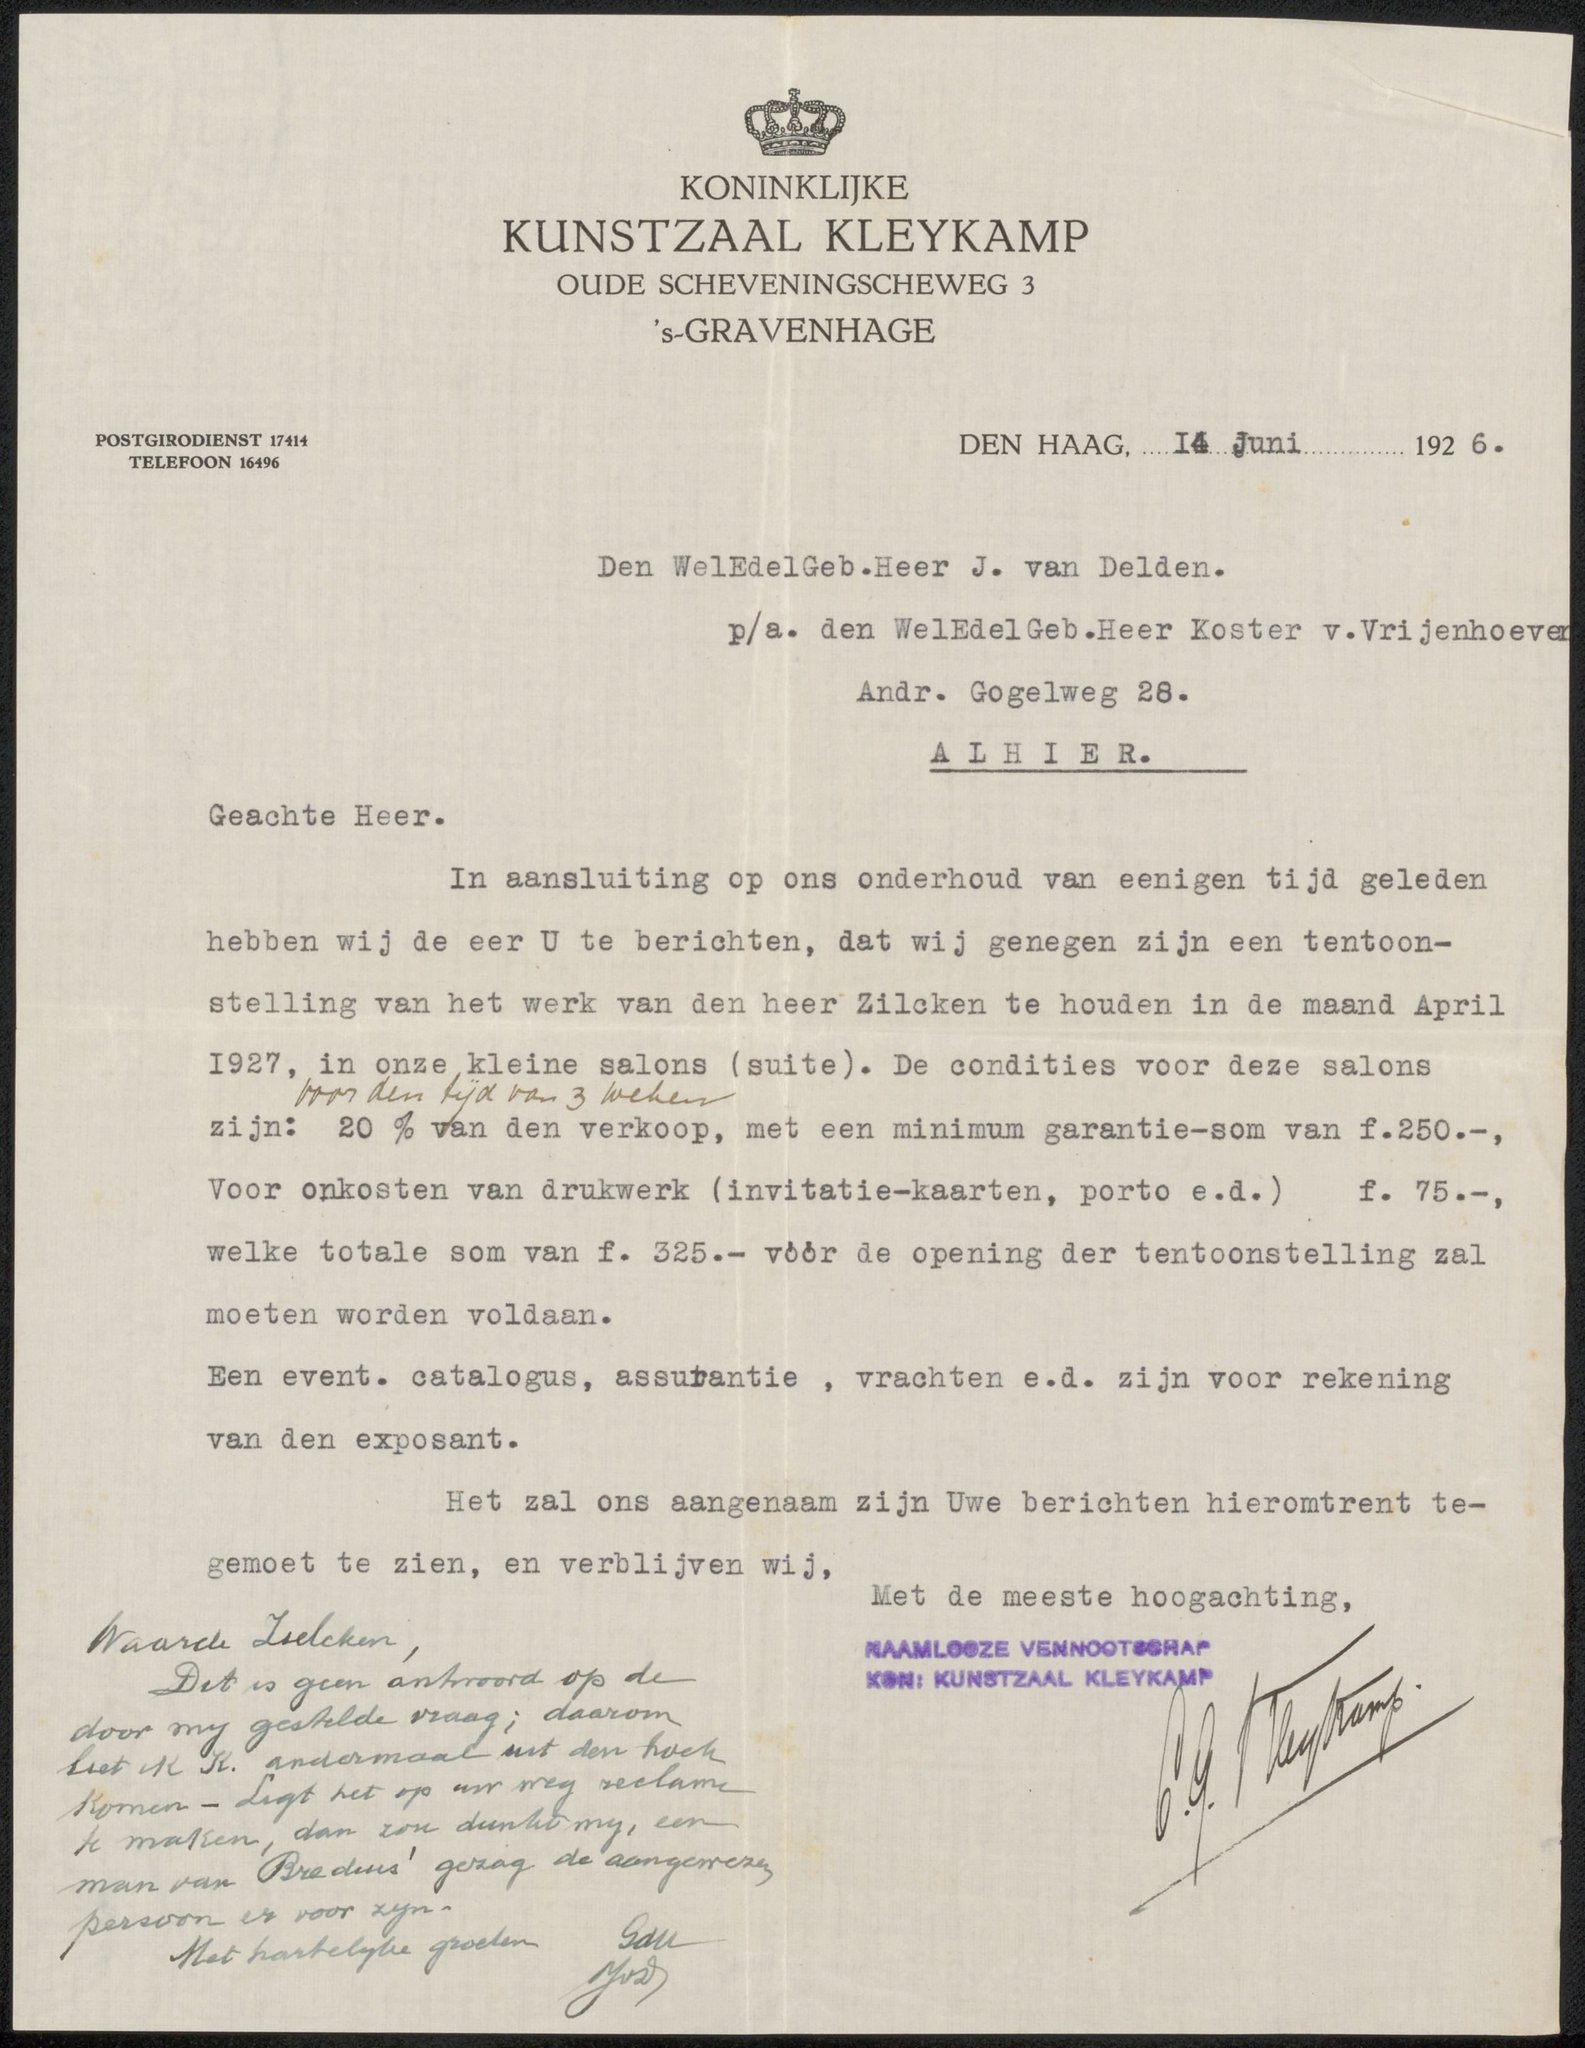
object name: letter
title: Brief aan J. van Delden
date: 1926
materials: ink, paper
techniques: pen, typewriting, writing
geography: the hague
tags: amsterdam, abraham bredius, painter, gerard delfgaauw, draughtsman, philip zilcken, exhibition ~ art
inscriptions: collector's mark: ‘RPK’